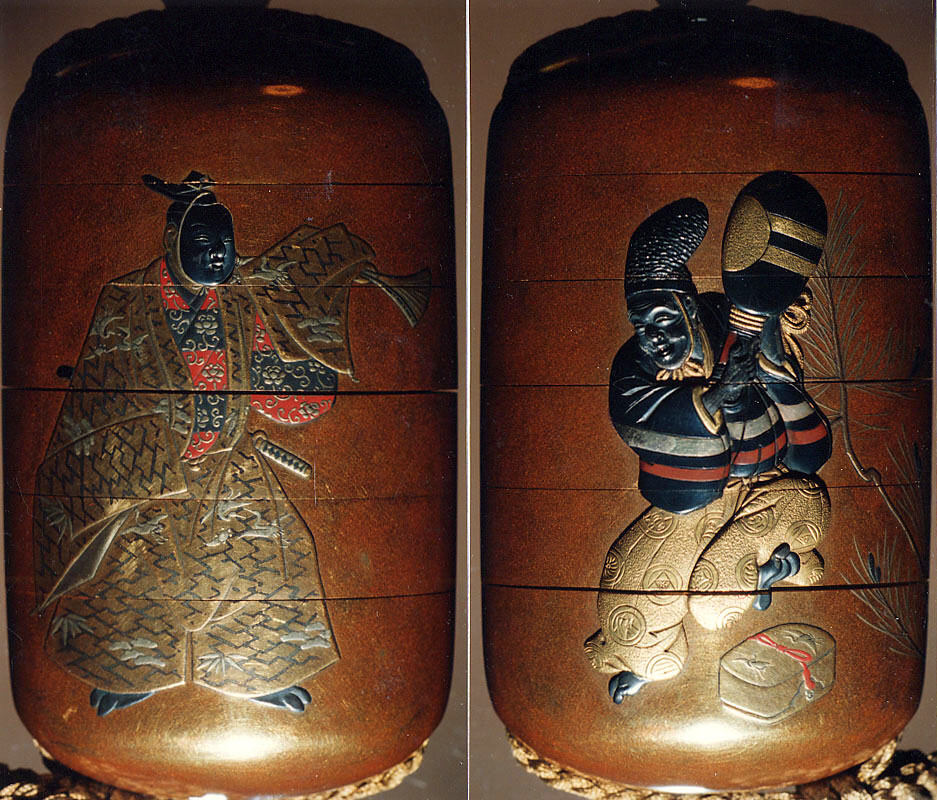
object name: inrō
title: Inrō with Kyōgen Dancer with Quiver from “The Monkey Skin Quiver” (obverse); Dancer with Fan and Sword (reverse)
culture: japanese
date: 1801-1850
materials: gold, ivory, lacquer, metal, silver, wood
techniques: carving, hiramakie, lacquer, maki-e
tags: fans,swords,men,dancers